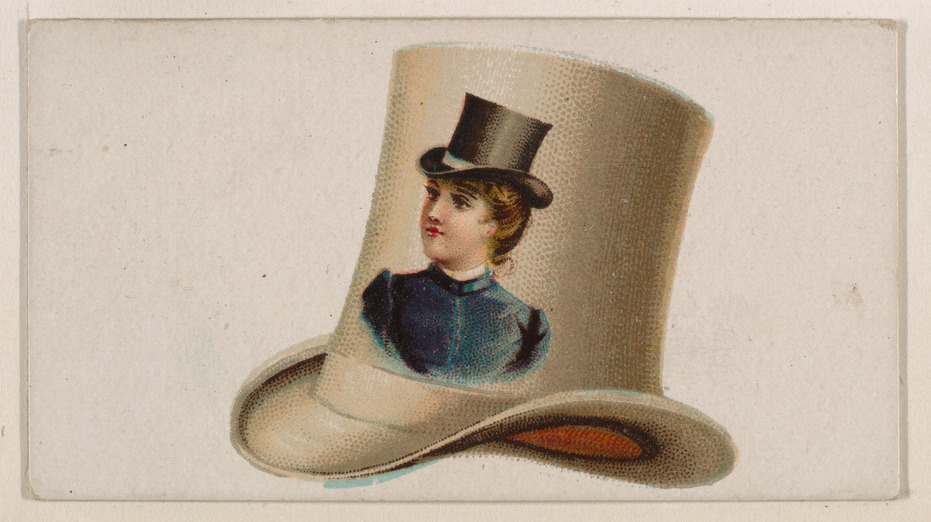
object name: print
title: Top hat, from the Novelties series (N228, Type 5) issued by Kinney Bros.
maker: kinney brothers tobacco company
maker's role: publisher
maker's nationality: american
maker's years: 1869-2011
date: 1889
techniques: color lithograph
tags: hats,women